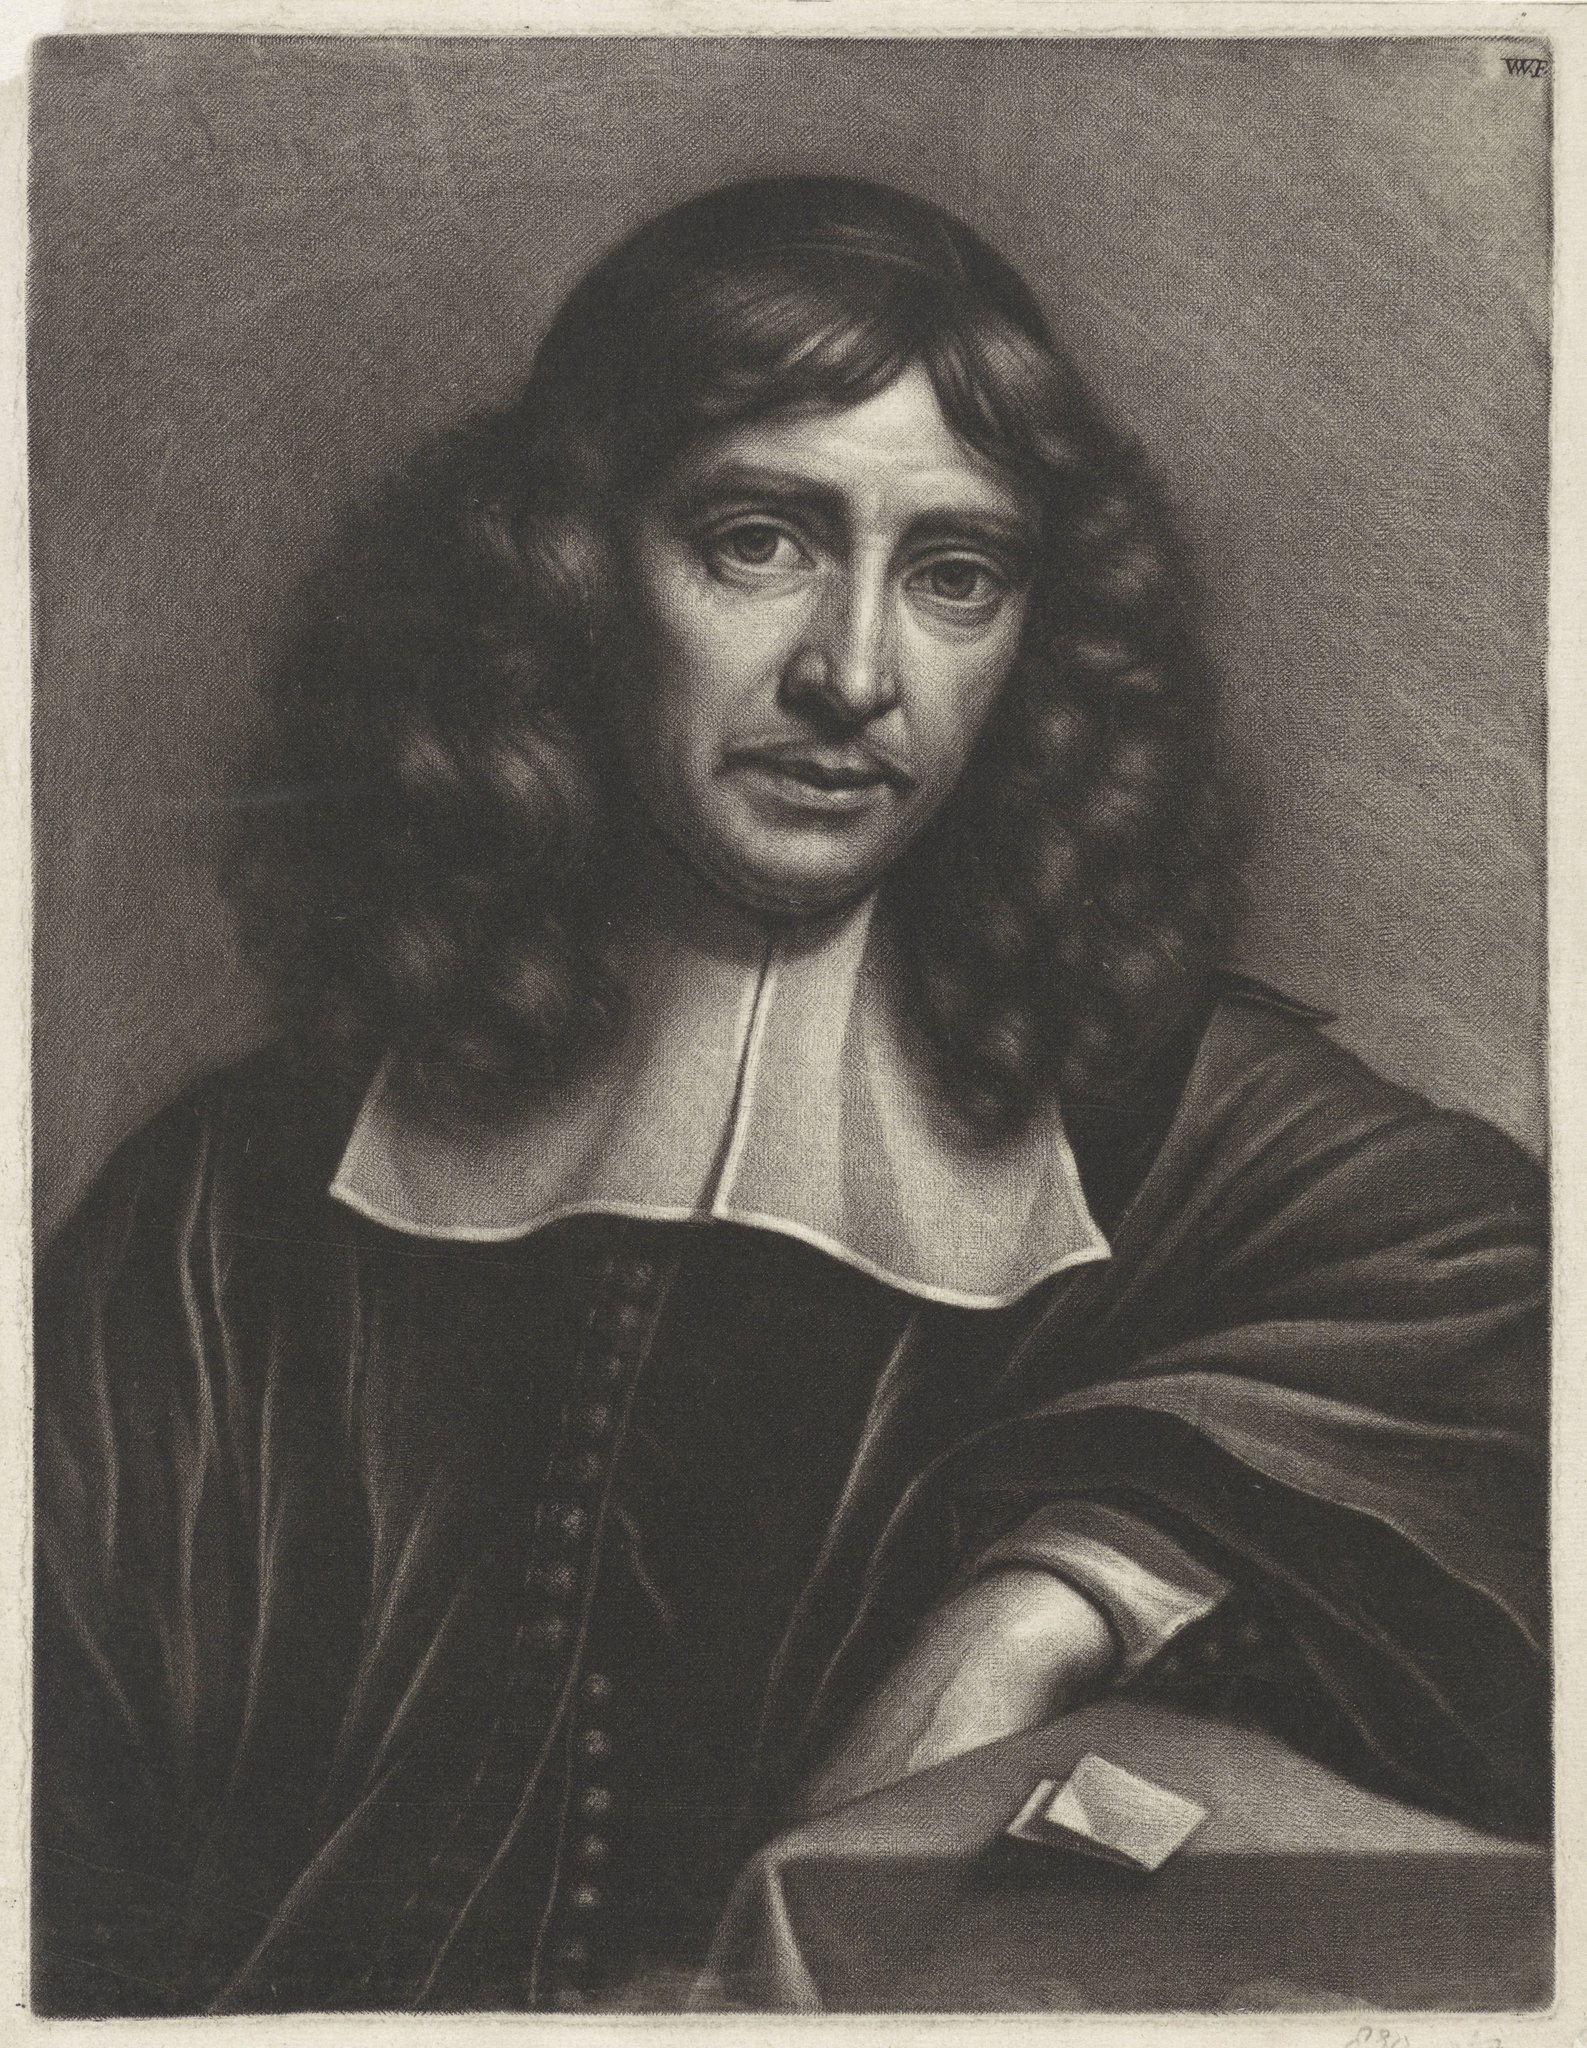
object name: print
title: Portret van de arts Philip Fontein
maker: wallerant vaillant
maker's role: draughtsman, painter, print maker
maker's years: 1623-1677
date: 1658-1677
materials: paper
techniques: mezzotint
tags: arts, philip fontein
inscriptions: collector's mark: Lugt 2228